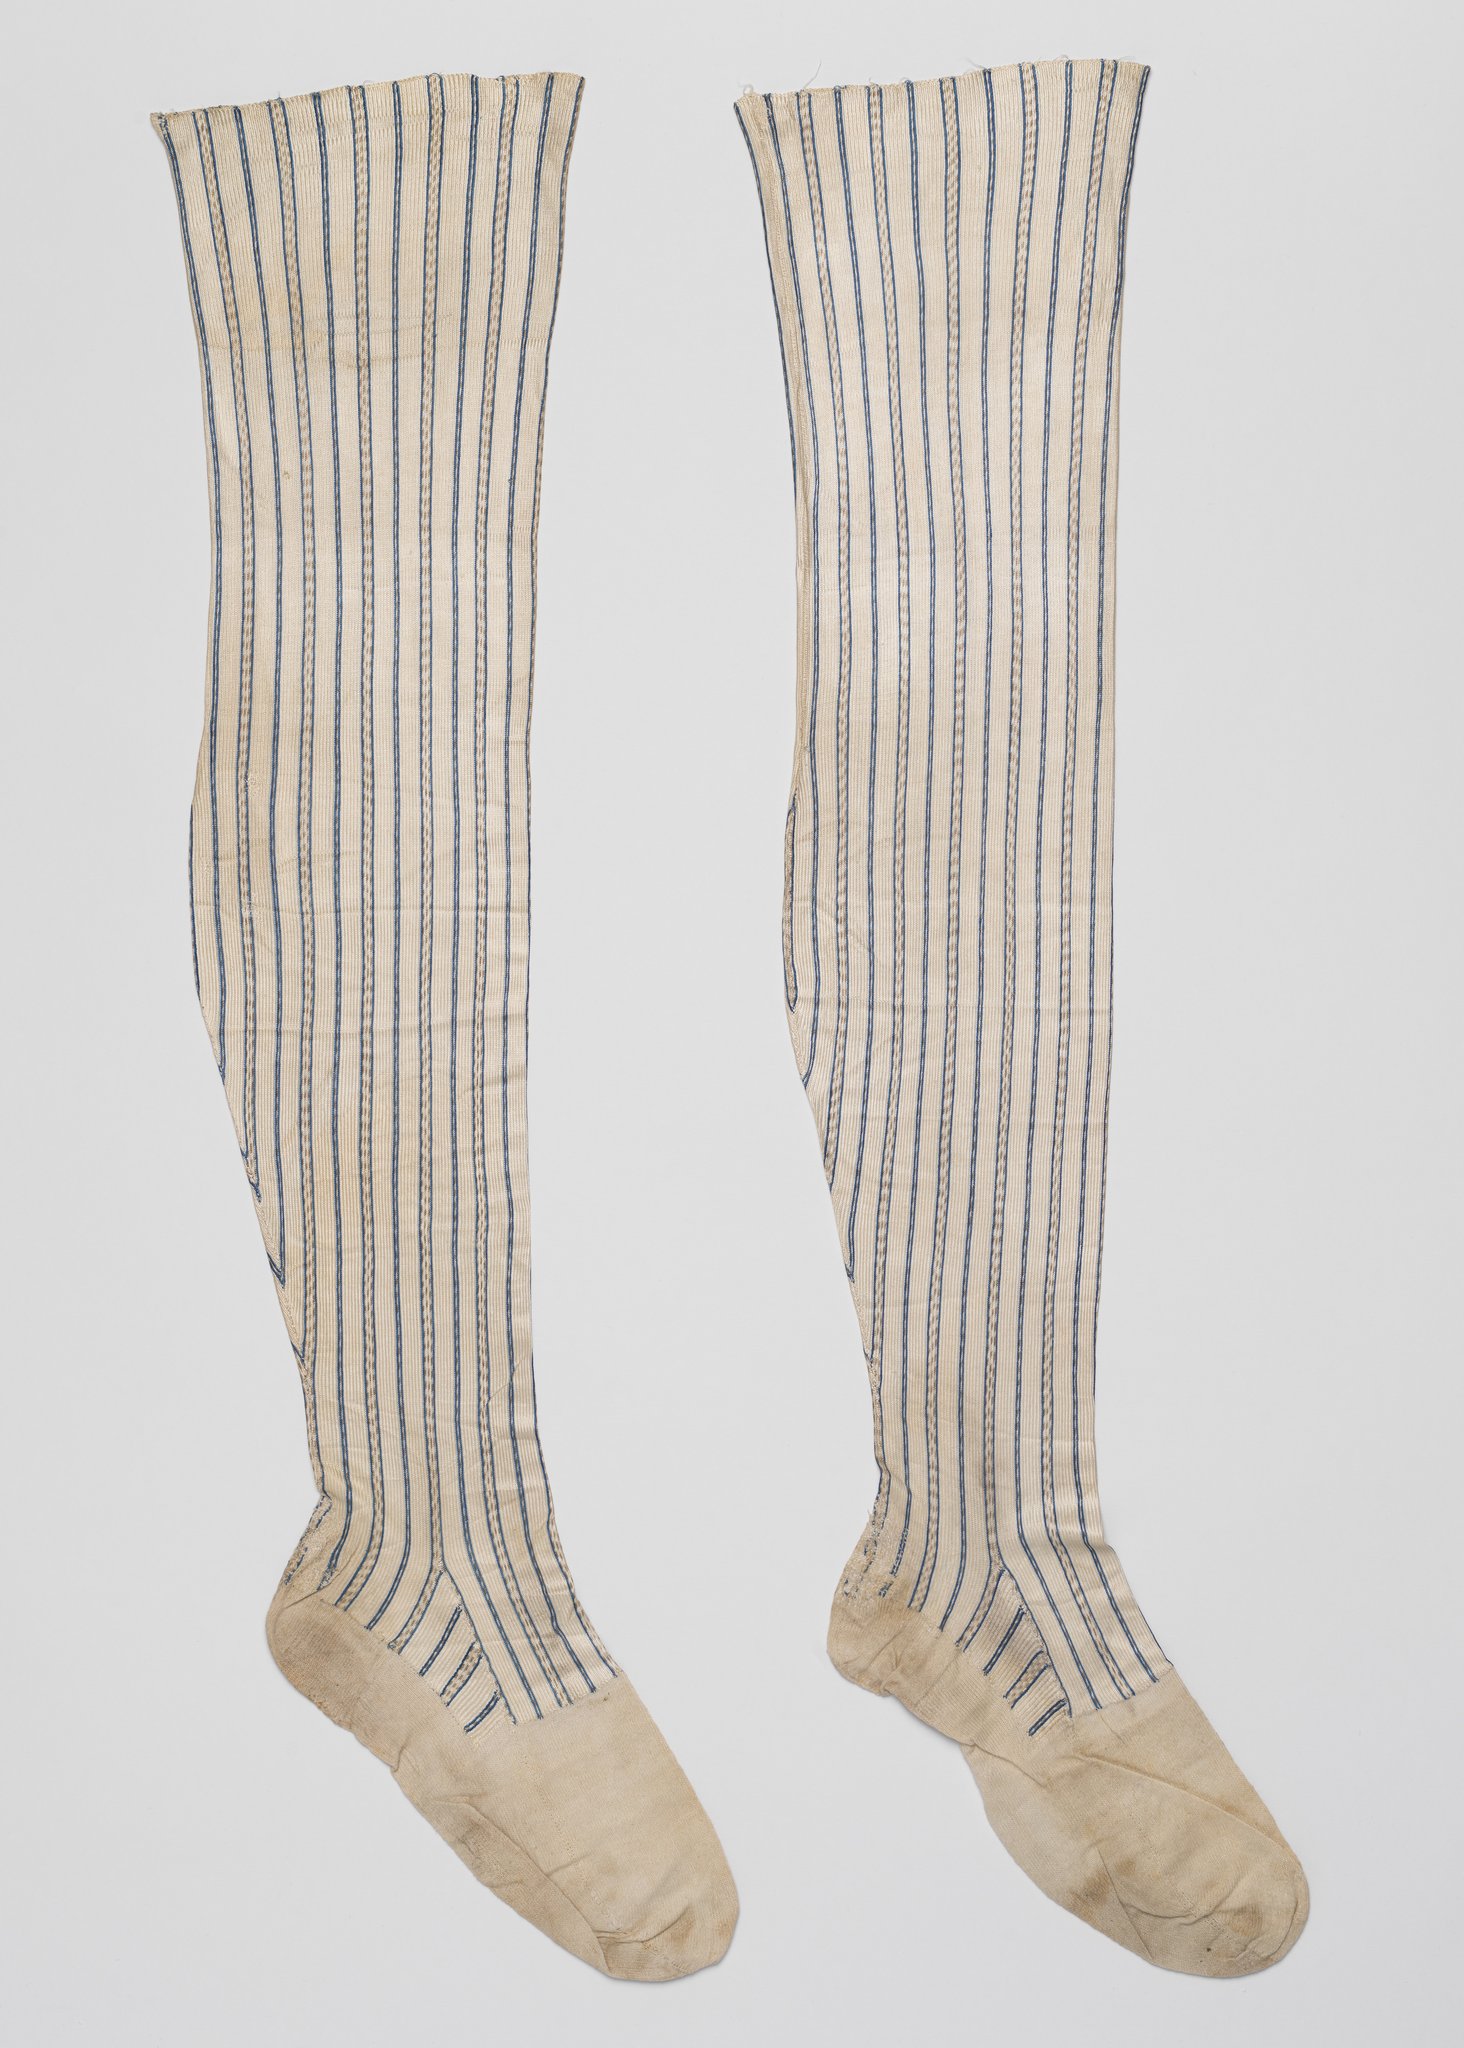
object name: stocking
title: Stockings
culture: british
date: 1775-1795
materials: cotton, silk